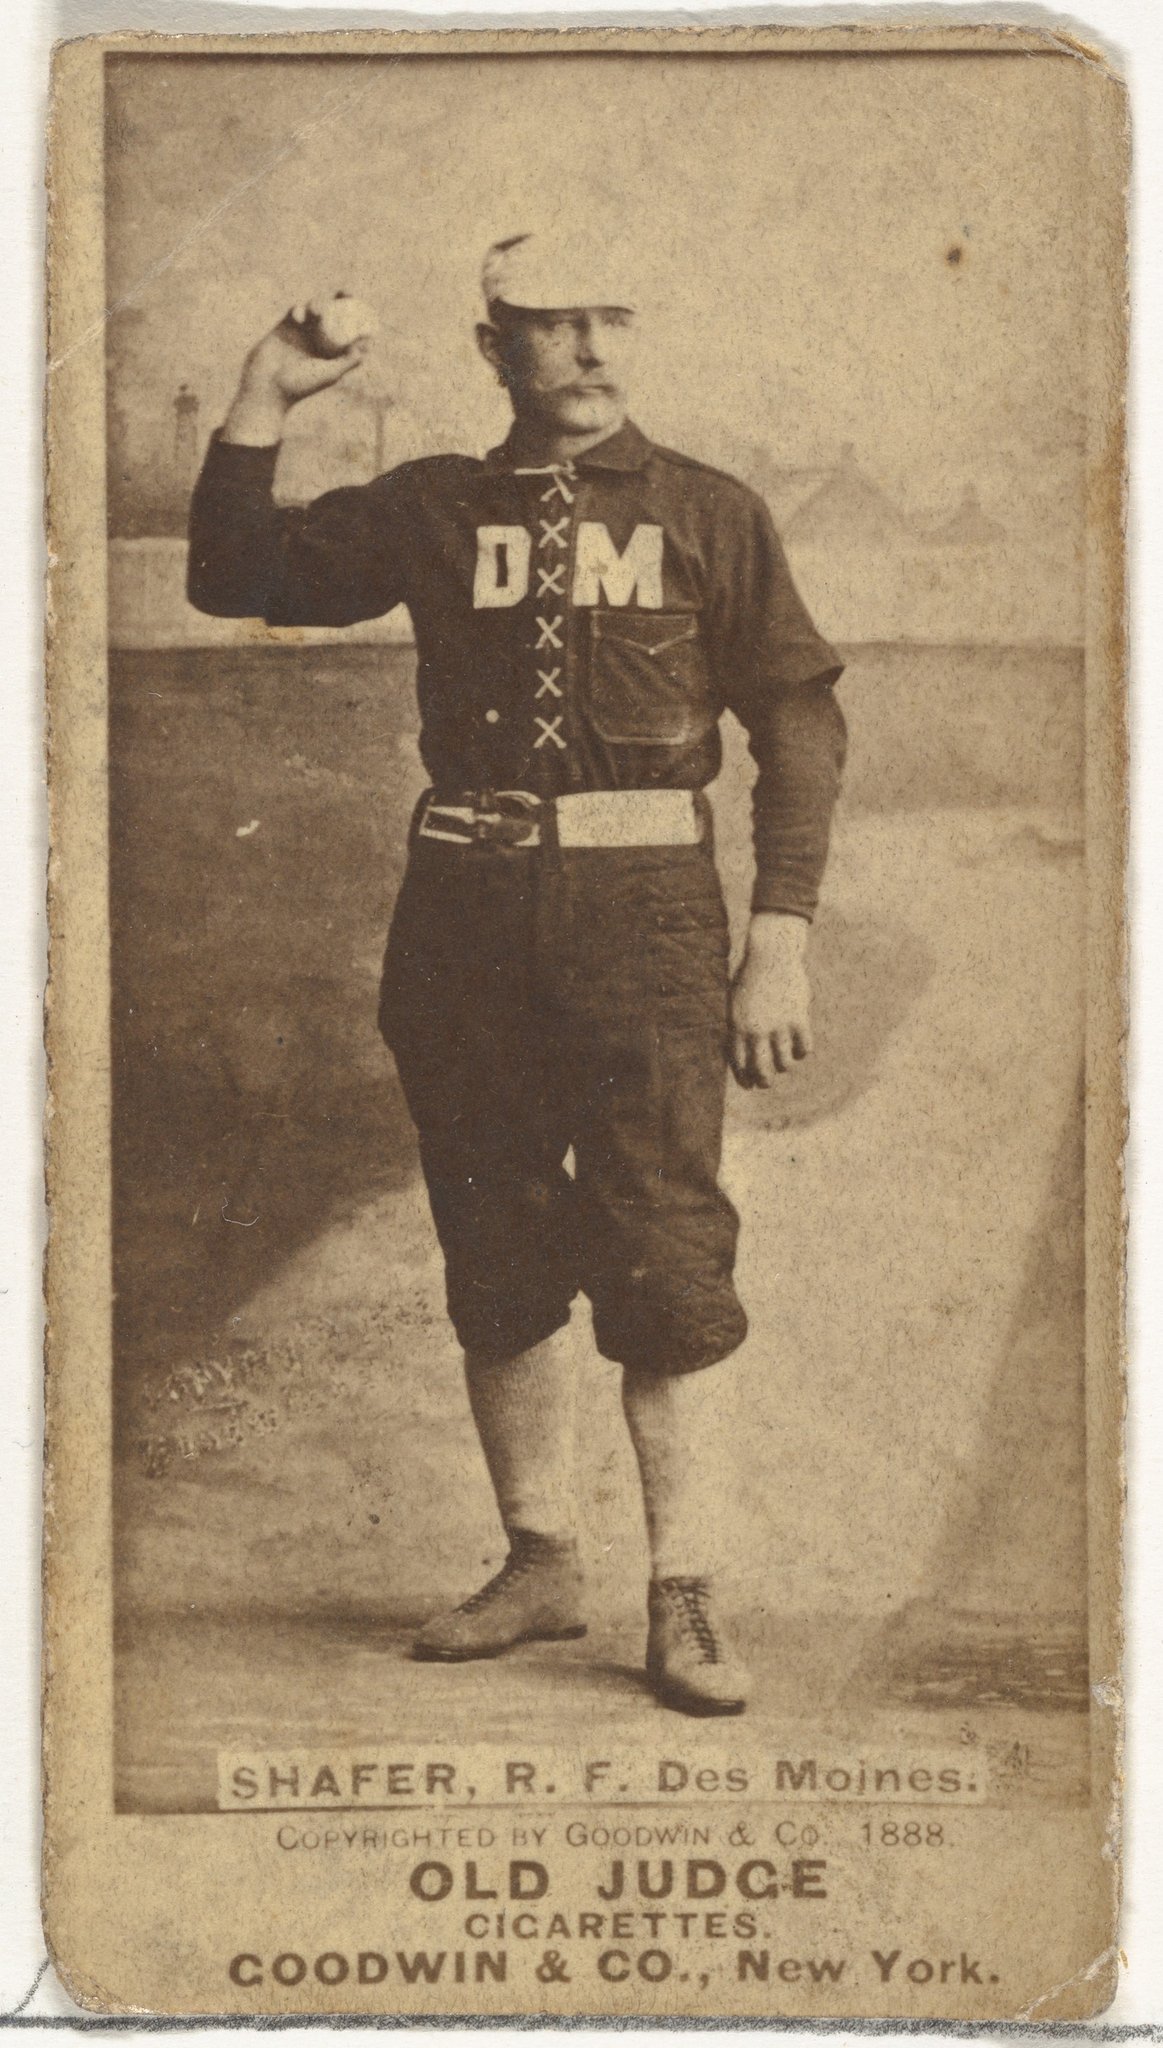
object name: baseball card, photograph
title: George W. Shafer, Right Field, Des Moines Prohibitionists, from the Old Judge series (N172) for Old Judge Cigarettes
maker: goodwin & company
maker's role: publisher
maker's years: 1850-1950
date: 1888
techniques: albumen silver print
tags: men,portraits,baseball,athletes